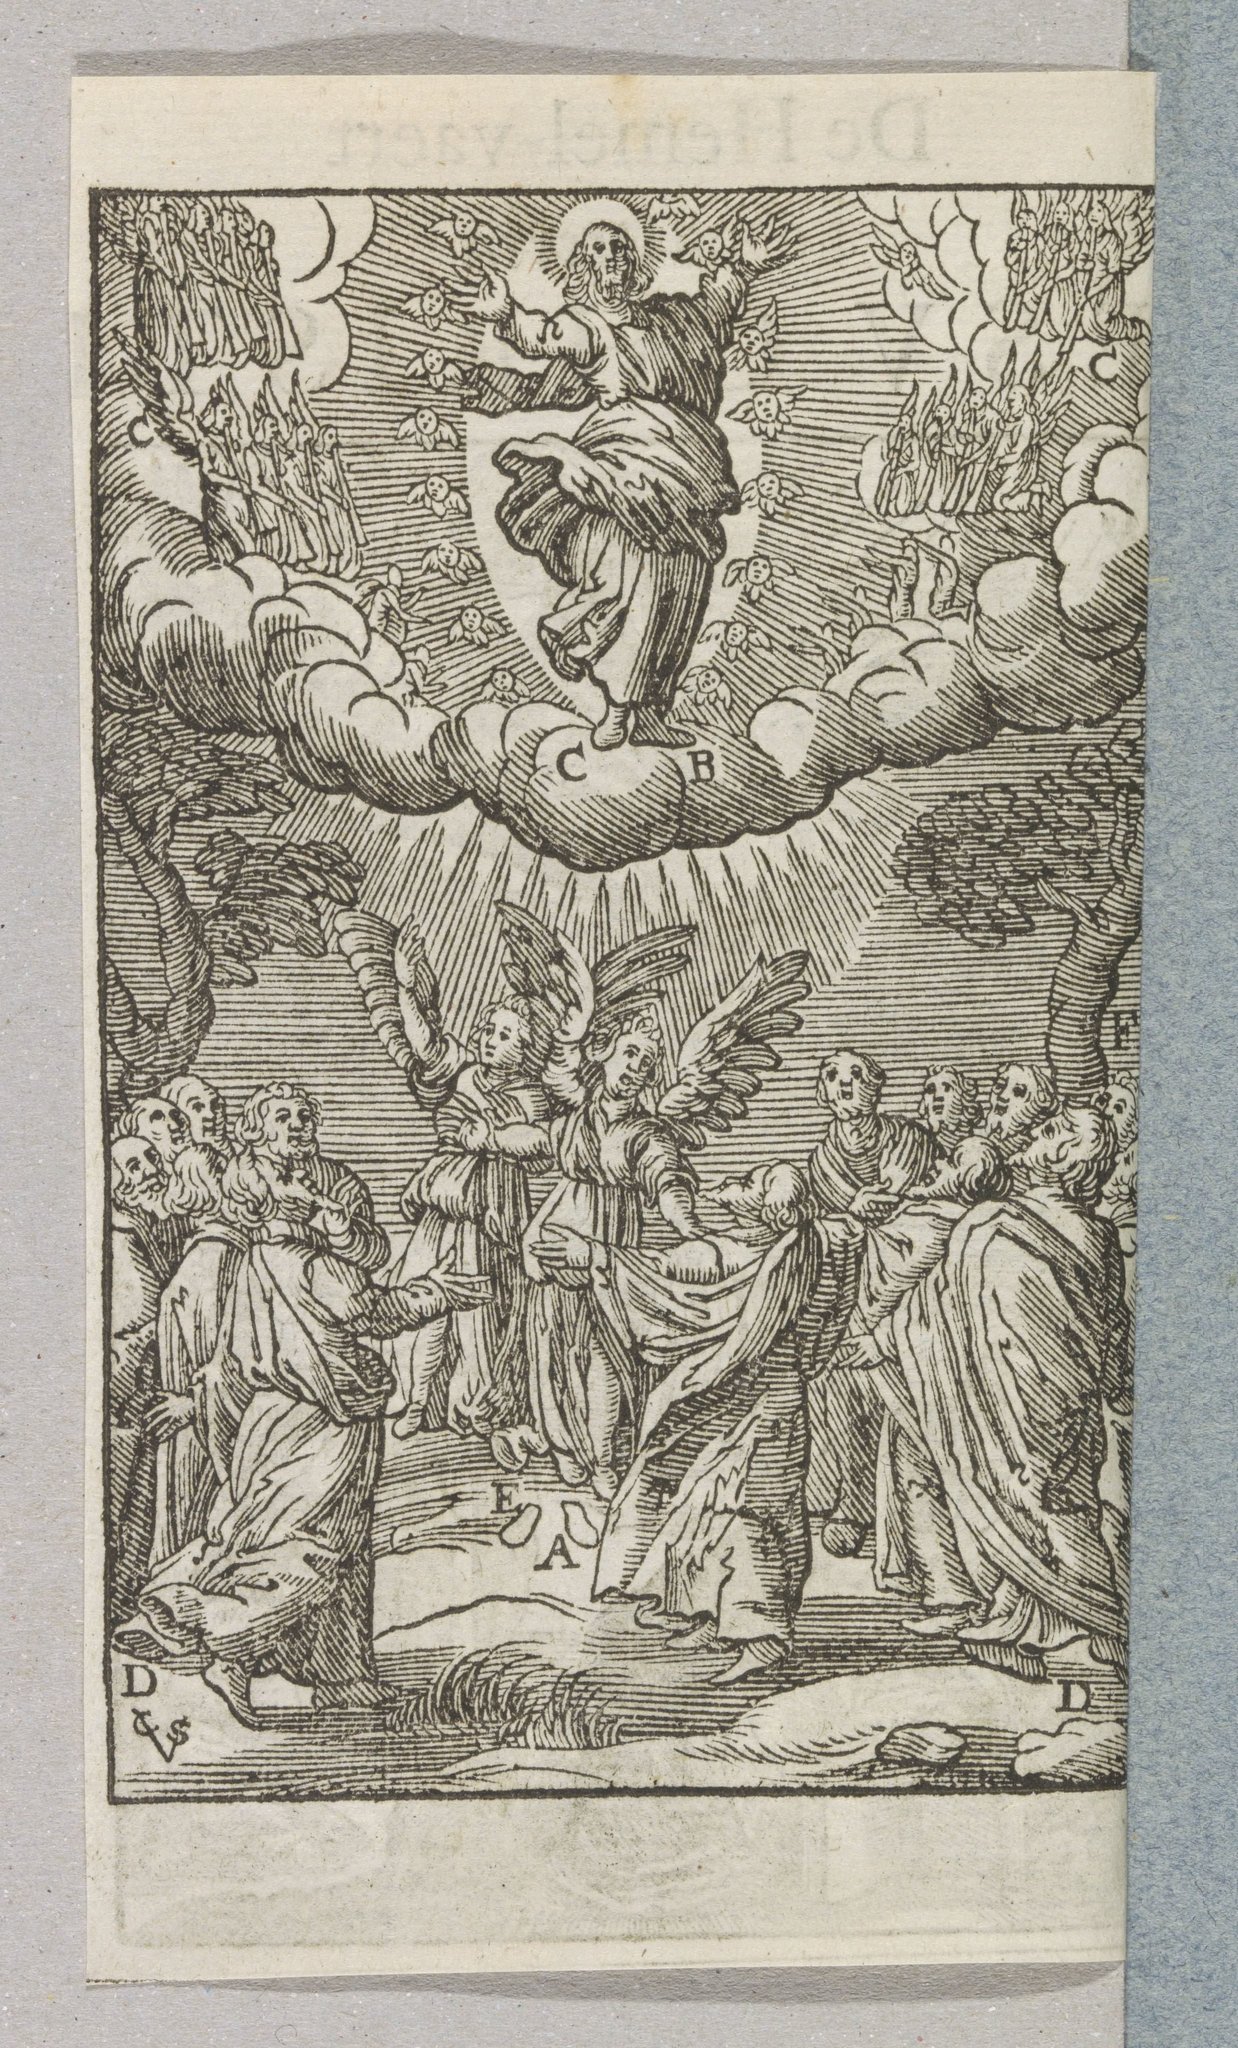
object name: print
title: Hemelvaart van Christus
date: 1629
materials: paper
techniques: woodcut, pasting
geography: antwerp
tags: the ascension (christ surrounded by radiant light or in a mandorla)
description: De prent is afkomstig uit een van de uitgaven van P.J. Paets uit Amsterdam. De prent wordt voor het eerst gebruikt in: Der Zielen Lust-hof. Leuven, I.Jacbosz voor P.J. Paets [= Amsterdam, P.J. Paets], 1629. De voorstelling is gekopieerd naar een prent van Johannes Wierix voor: Nadal, Jerónimo. Evangelicae Historiae Imagines. Antwerpen, M. Nutius, 1593.